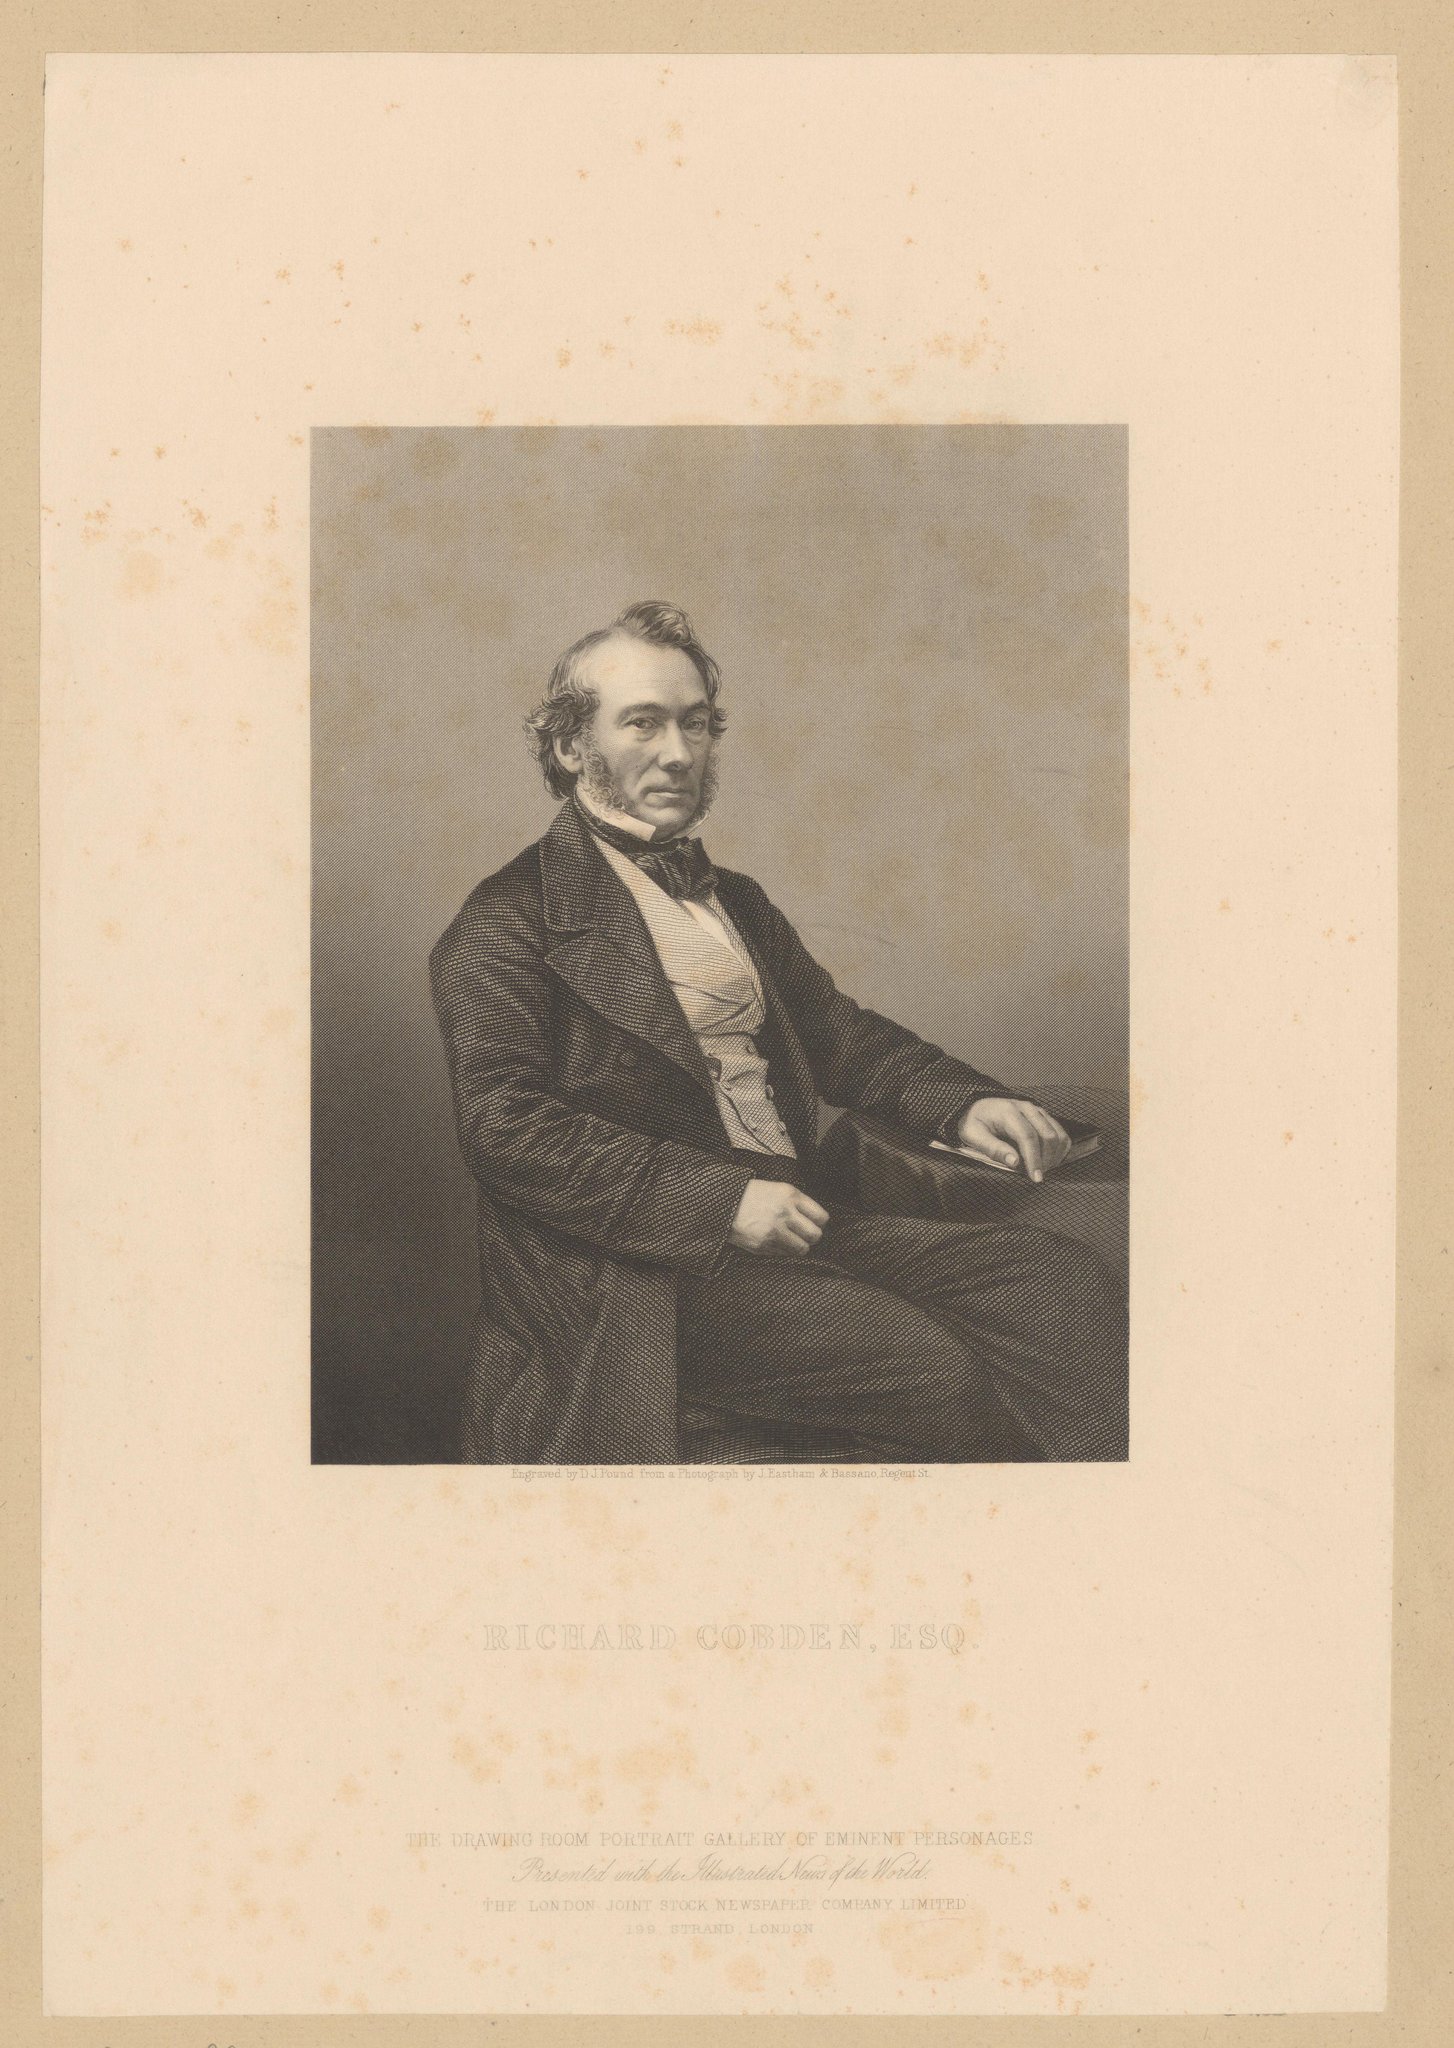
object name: book illustration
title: Richard Cobden, Esq.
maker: daniel john pound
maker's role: print maker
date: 1859-1862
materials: paper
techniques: engraving, etching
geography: manchester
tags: politician, manufacturer, historical persons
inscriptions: collector's mark: Lugt 2228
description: Prent uit: The drawing-room portrait gallery of eminent personages. Londen: London Joint Stock Newspaper Company, 1859-1862.